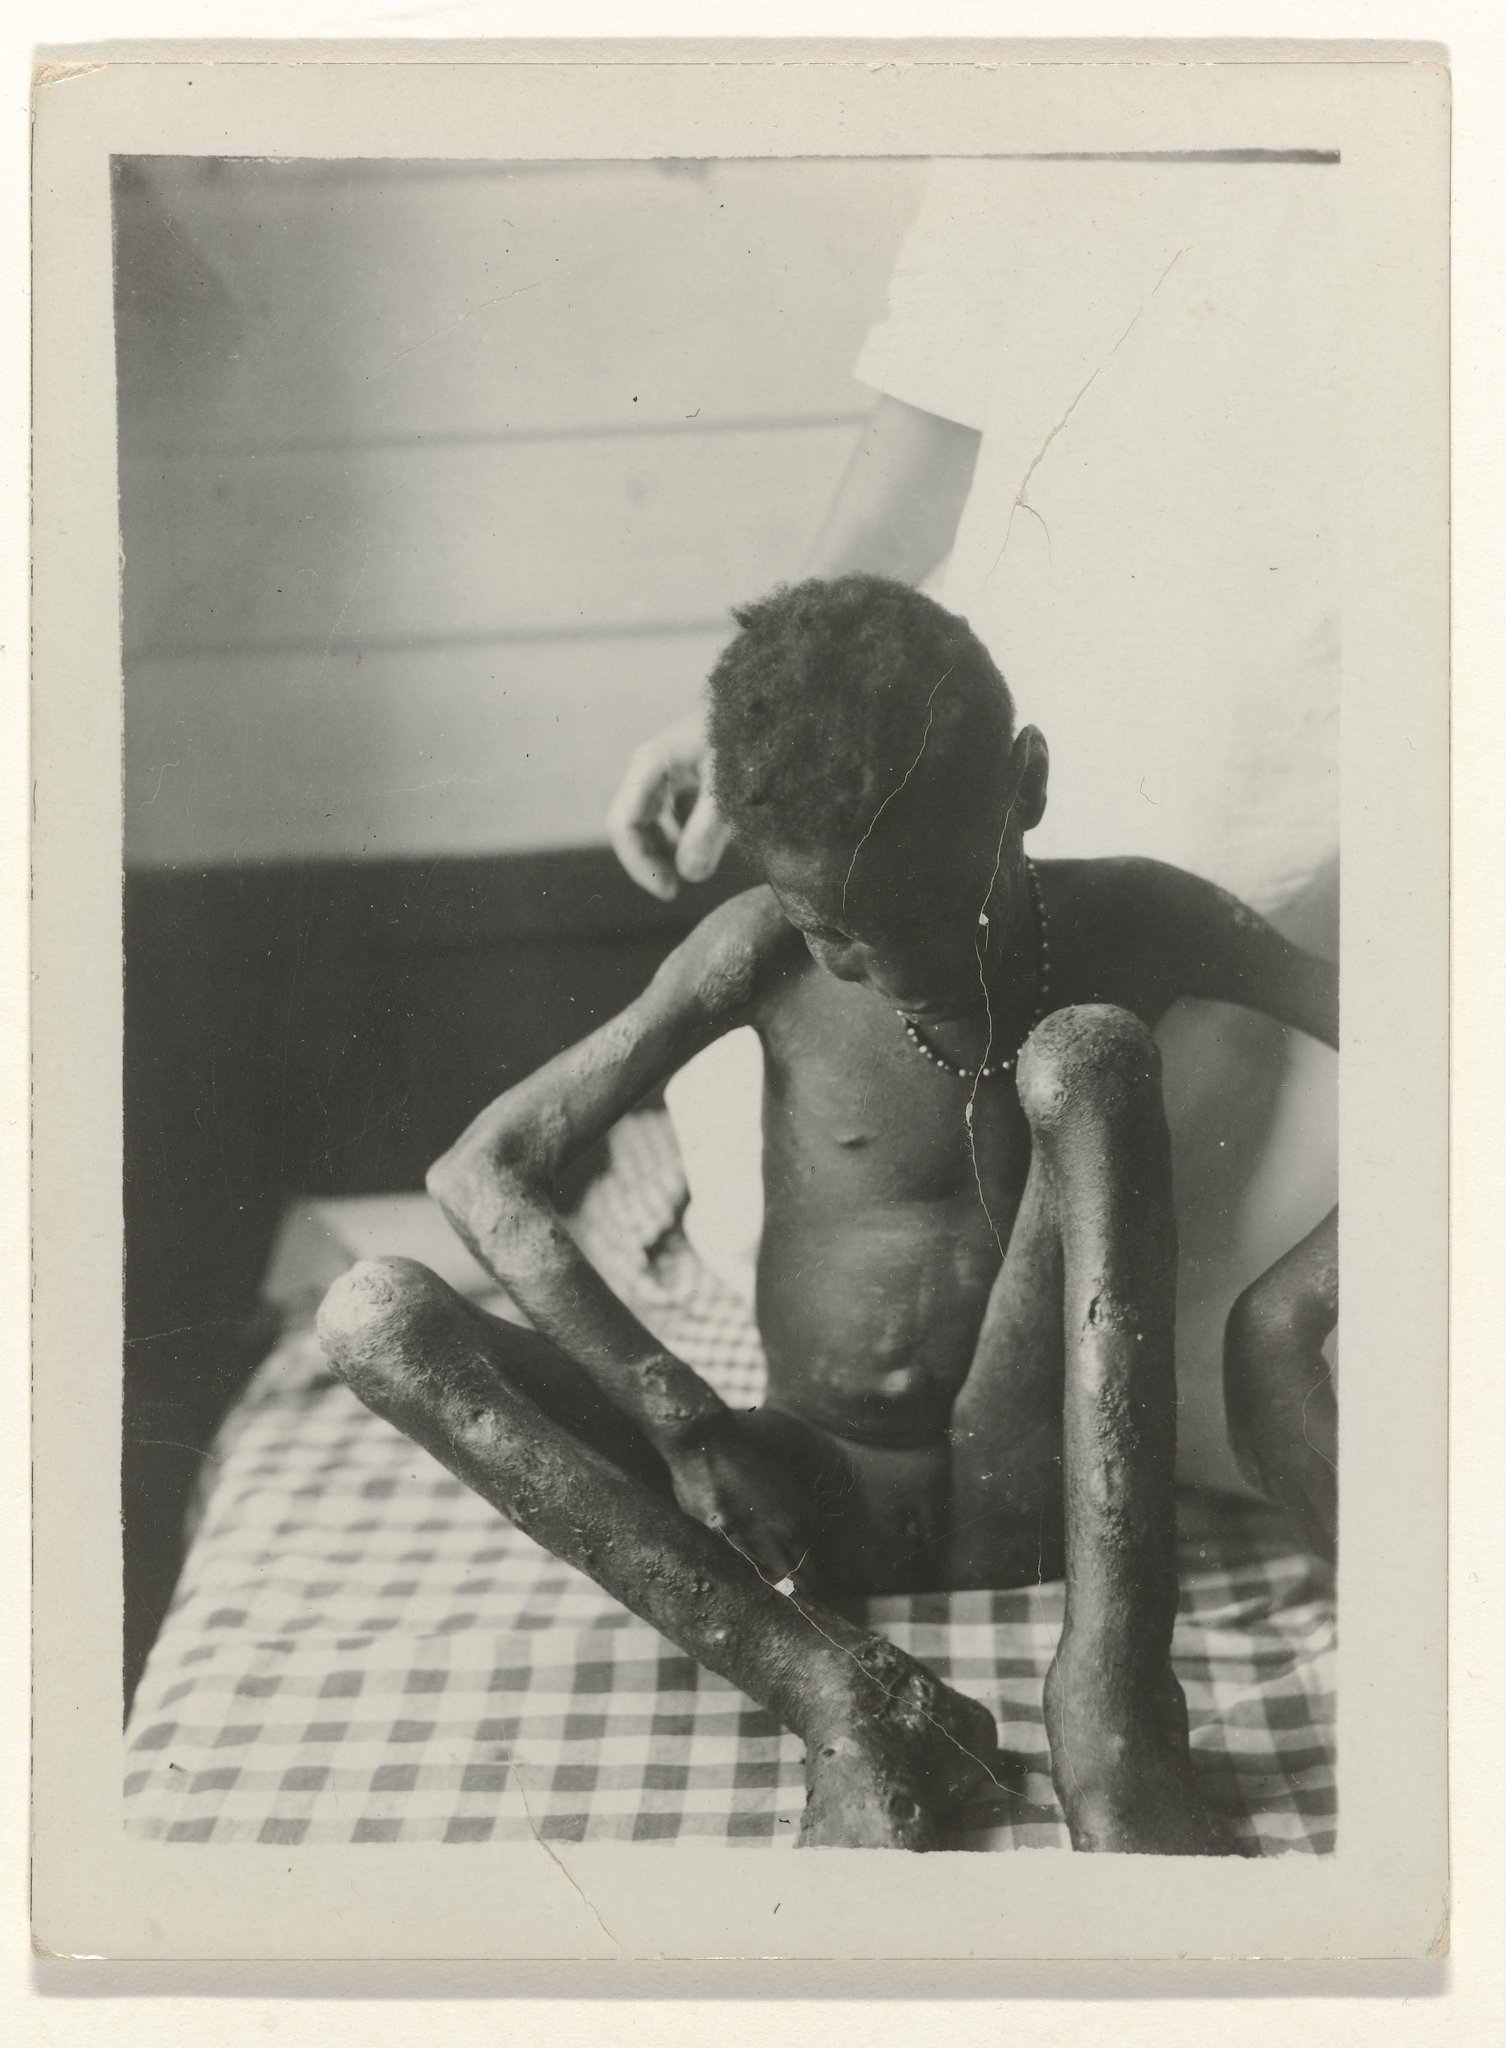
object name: photograph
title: Meisje met lepra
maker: Anonymous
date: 1929-1930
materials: photographic support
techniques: photography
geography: suriname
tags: leprosy